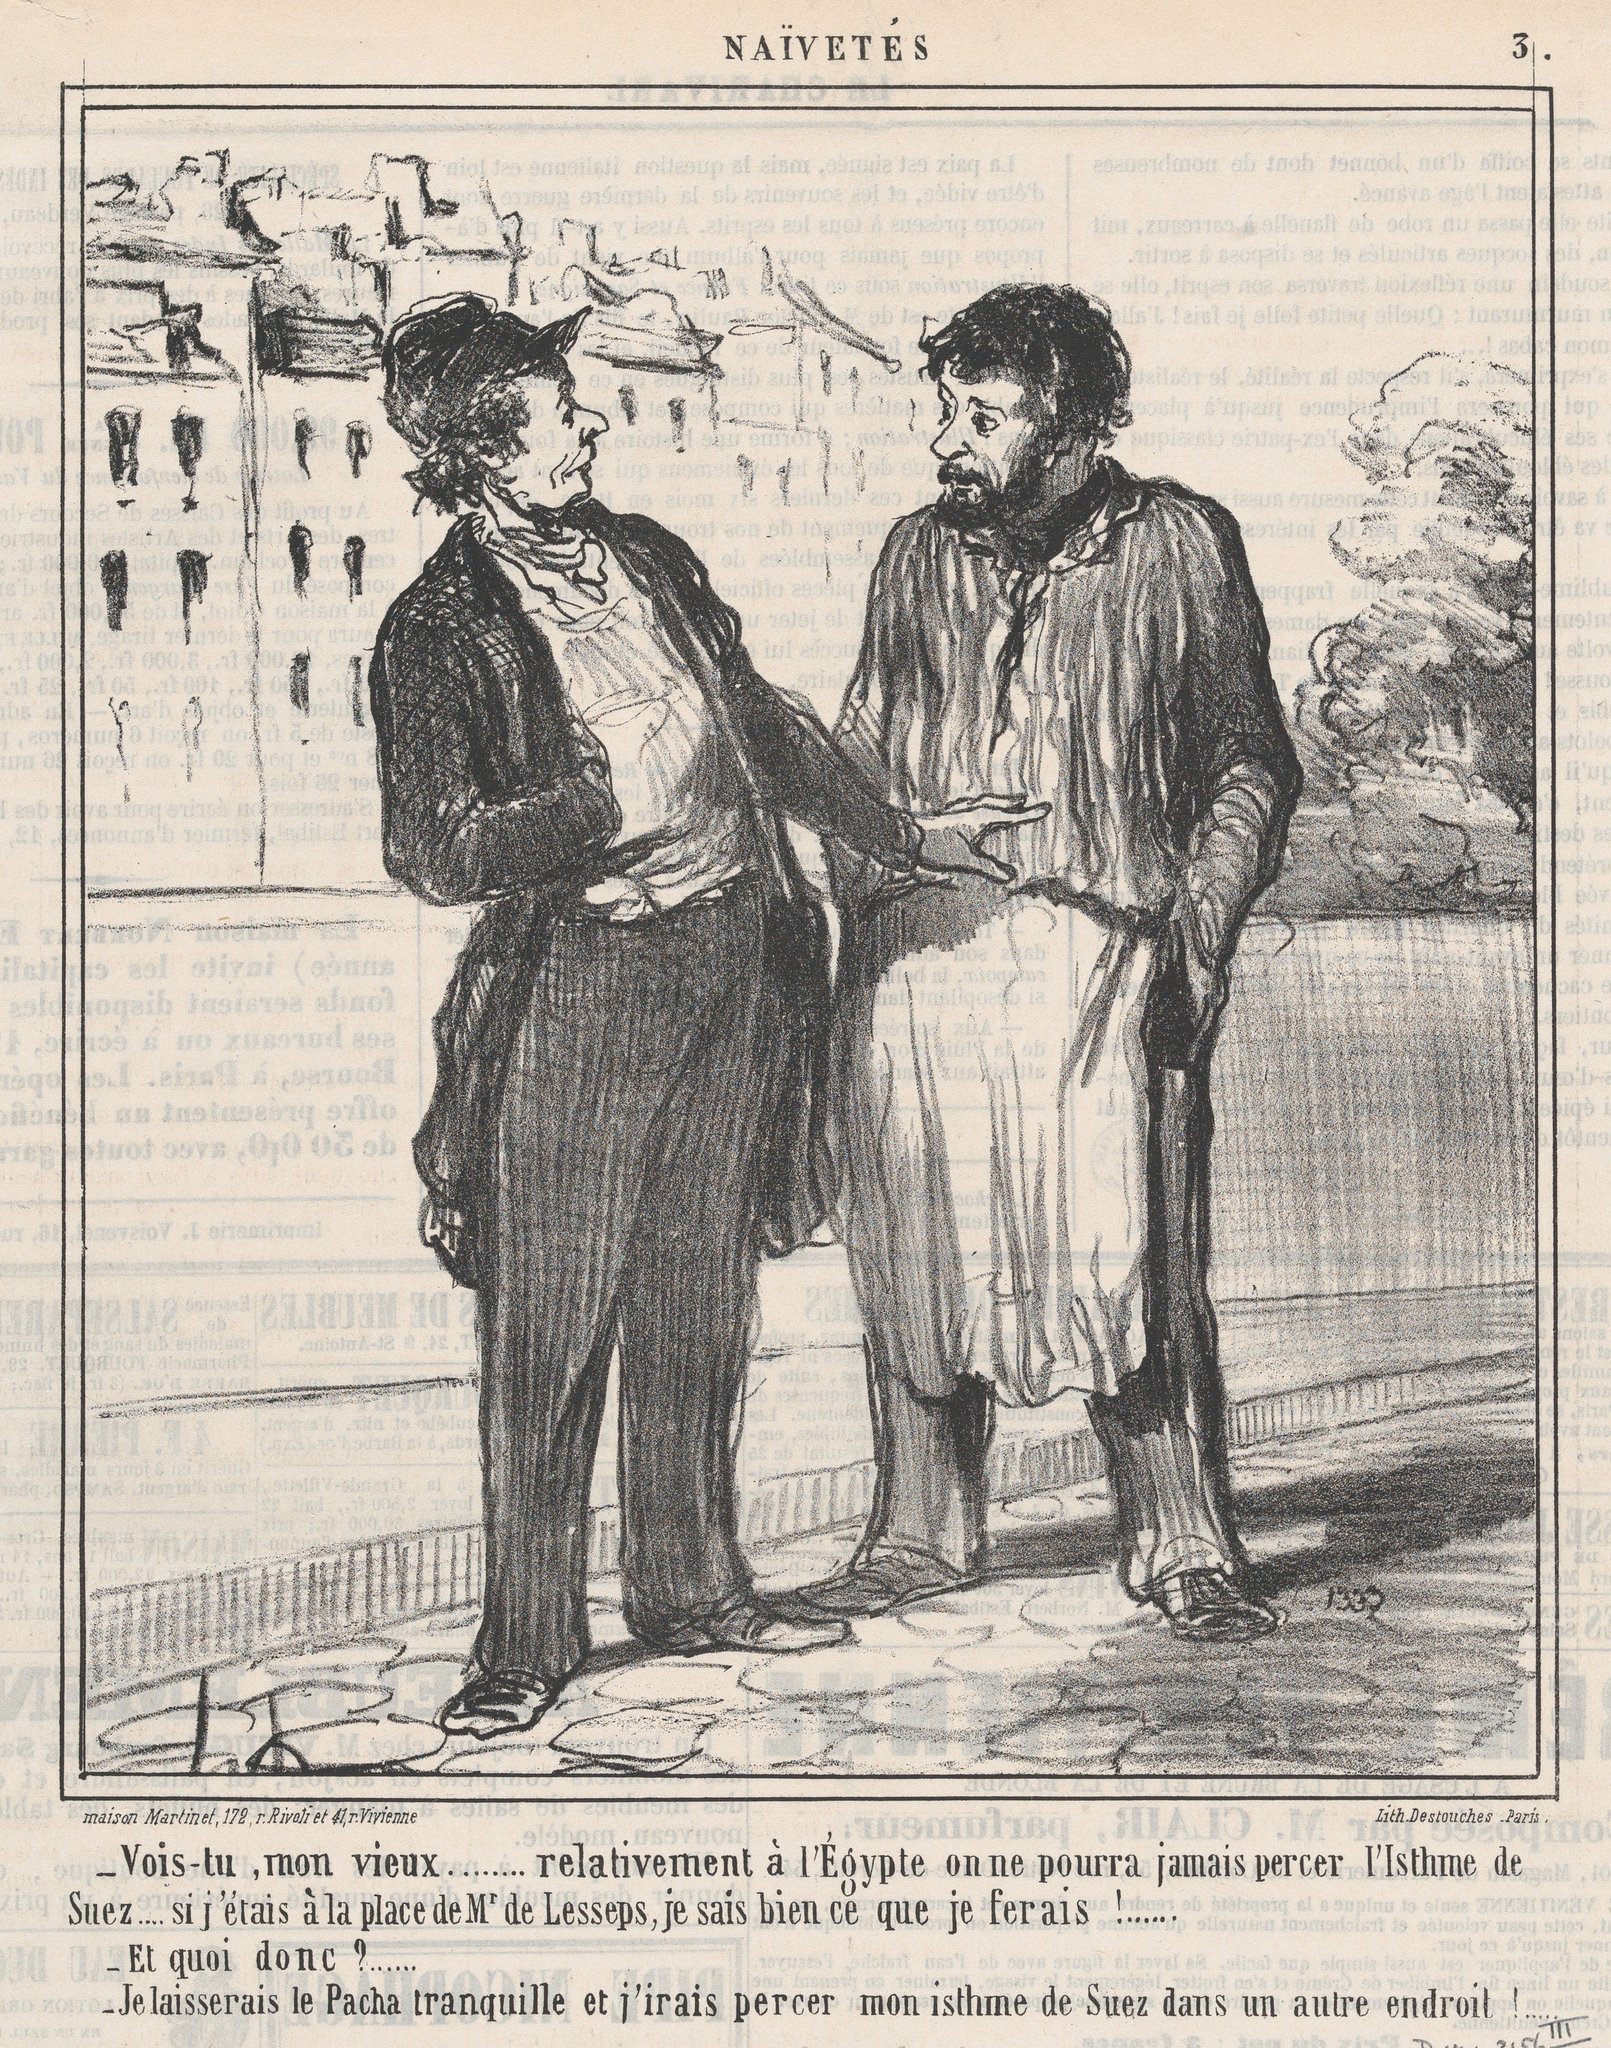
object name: print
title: Vois-tu, mon vieux..... relativement à l'Égypte on ne pourra jamais percer l'Isthme de Suez.... si j'étais à la place de Mr. de Lesspes, je sais bien ce que je ferais!....., from Naïvetés, published in Le Charivari, November 23, 1859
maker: honoré daumier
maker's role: artist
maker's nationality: french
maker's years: 1808-1879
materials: paper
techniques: lithograph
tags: men